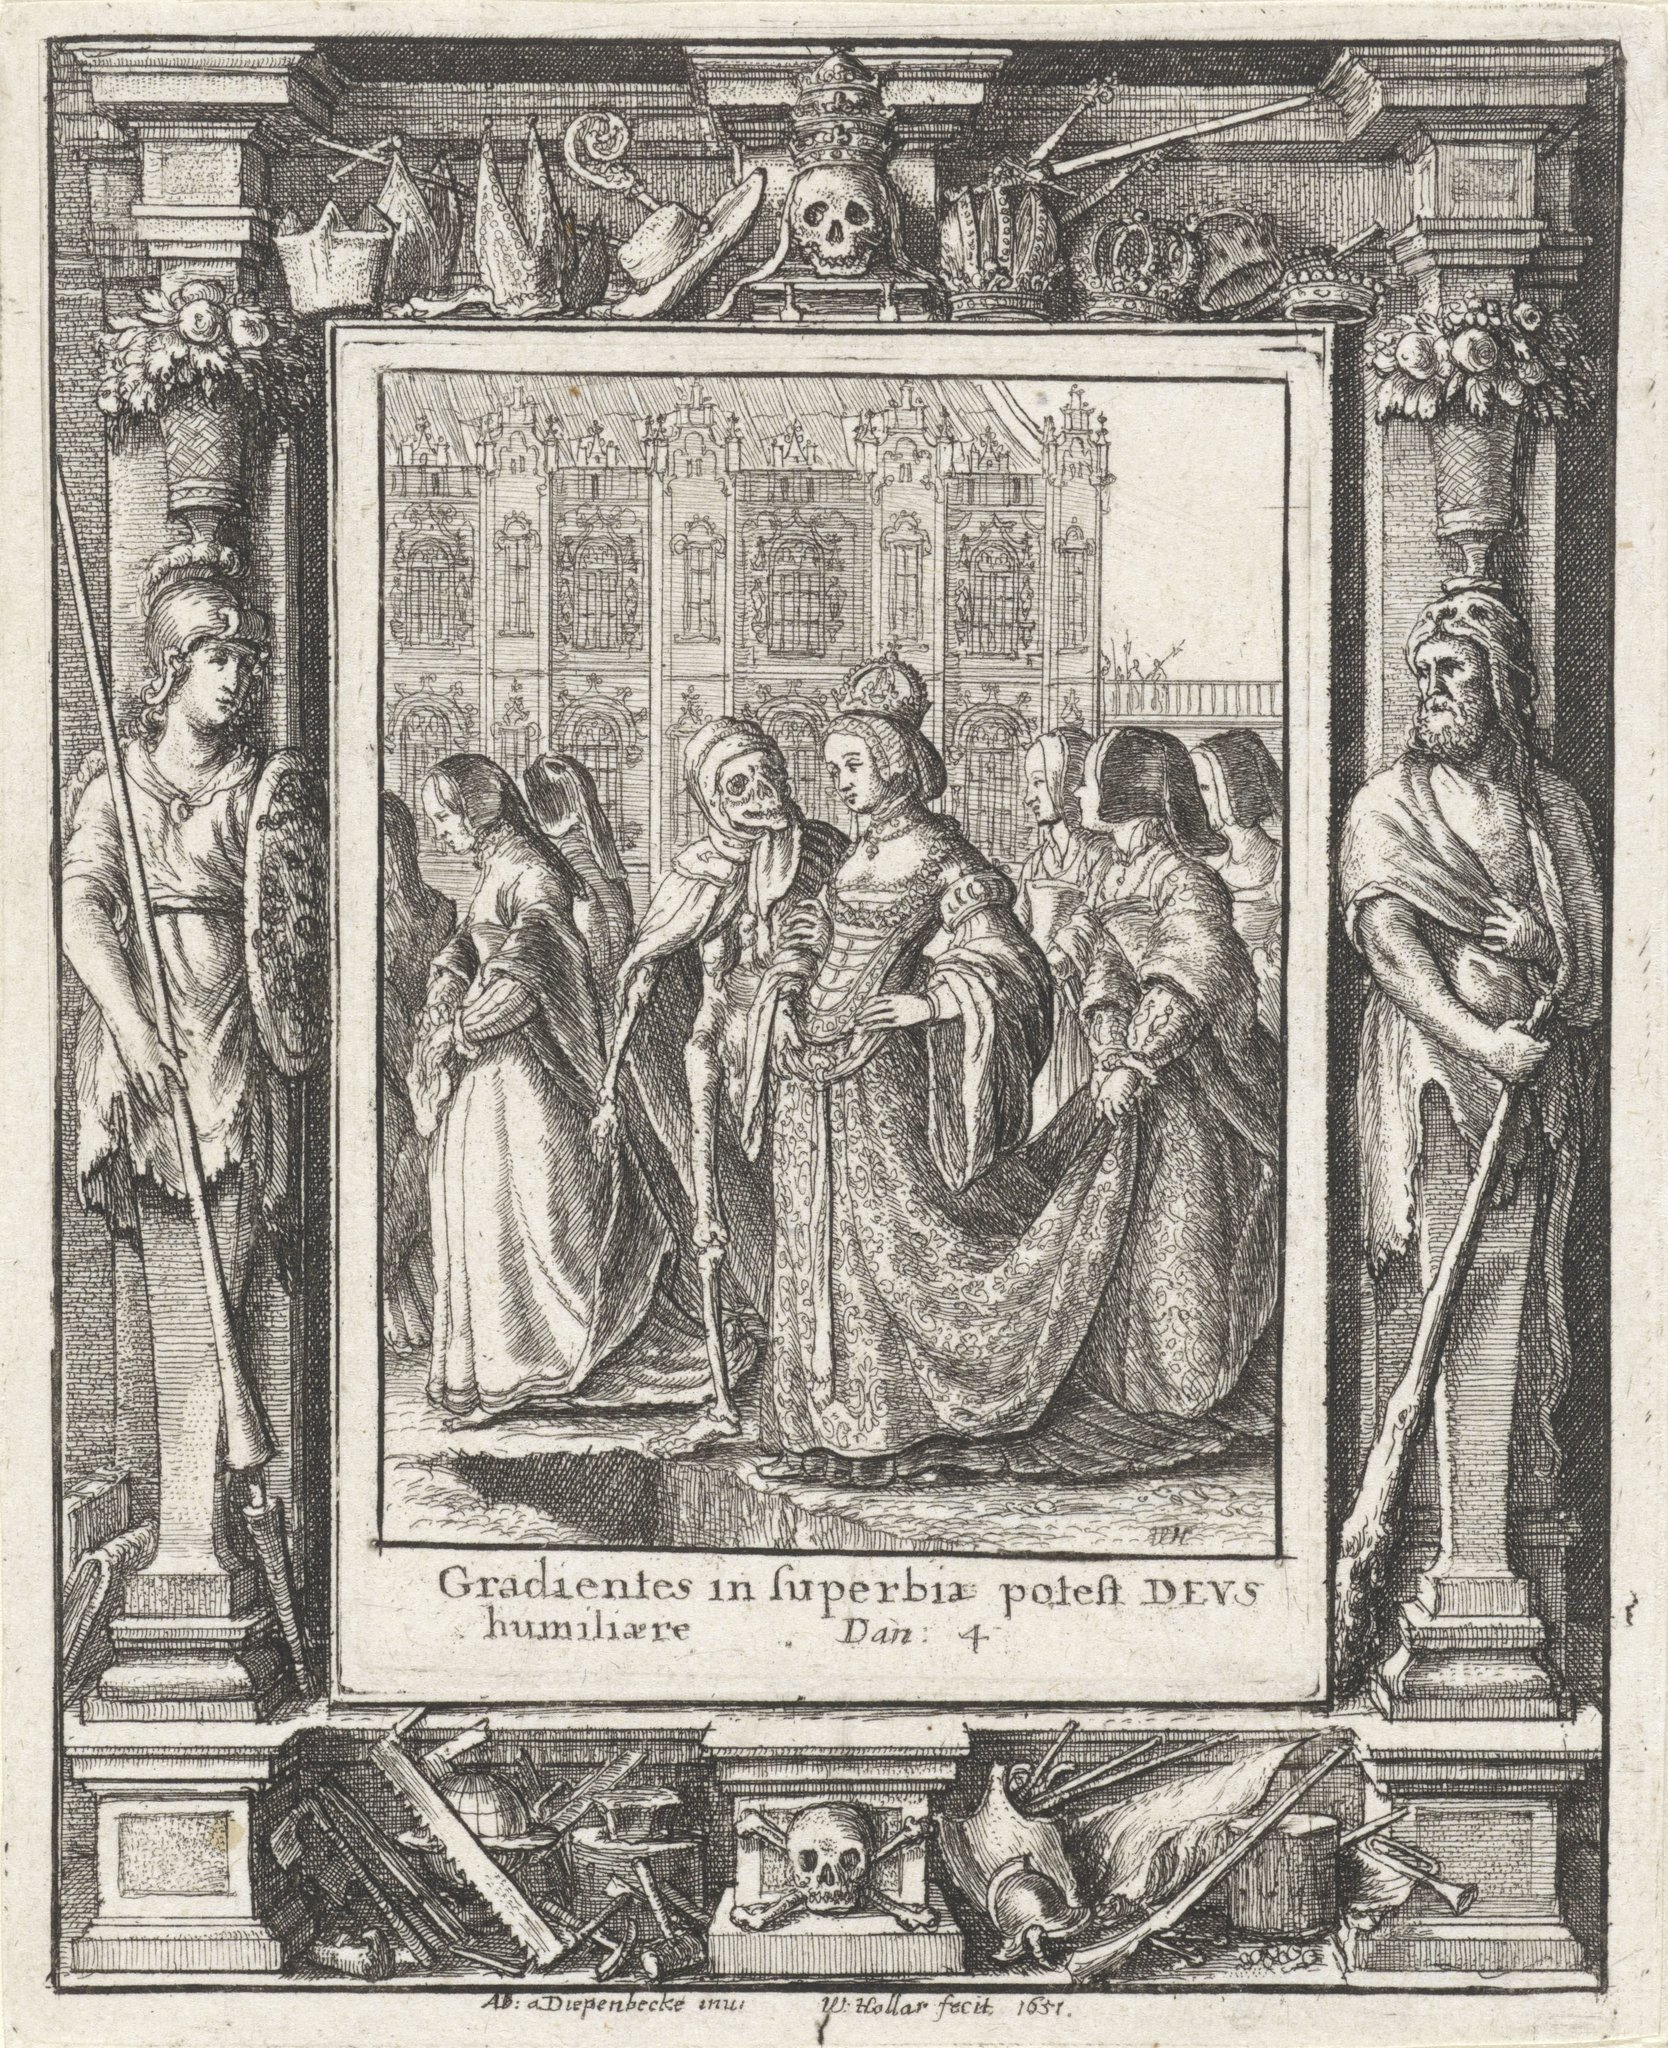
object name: print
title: Dodendans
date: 1651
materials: paper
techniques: etching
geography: antwerp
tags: (story of) hercules (heracles), (story of) minerva (pallas, athena), dance of death; death together with one or more human beings, ruler, sovereign - bb - female ruler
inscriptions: collector's mark: Lugt 2228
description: De keizerin wandelt met haar hofdames in begeleiding van de Dood. Zevende prent uit een reeks van 30 dodendansprenten; met een omlijsting met Minerva en Hercules.